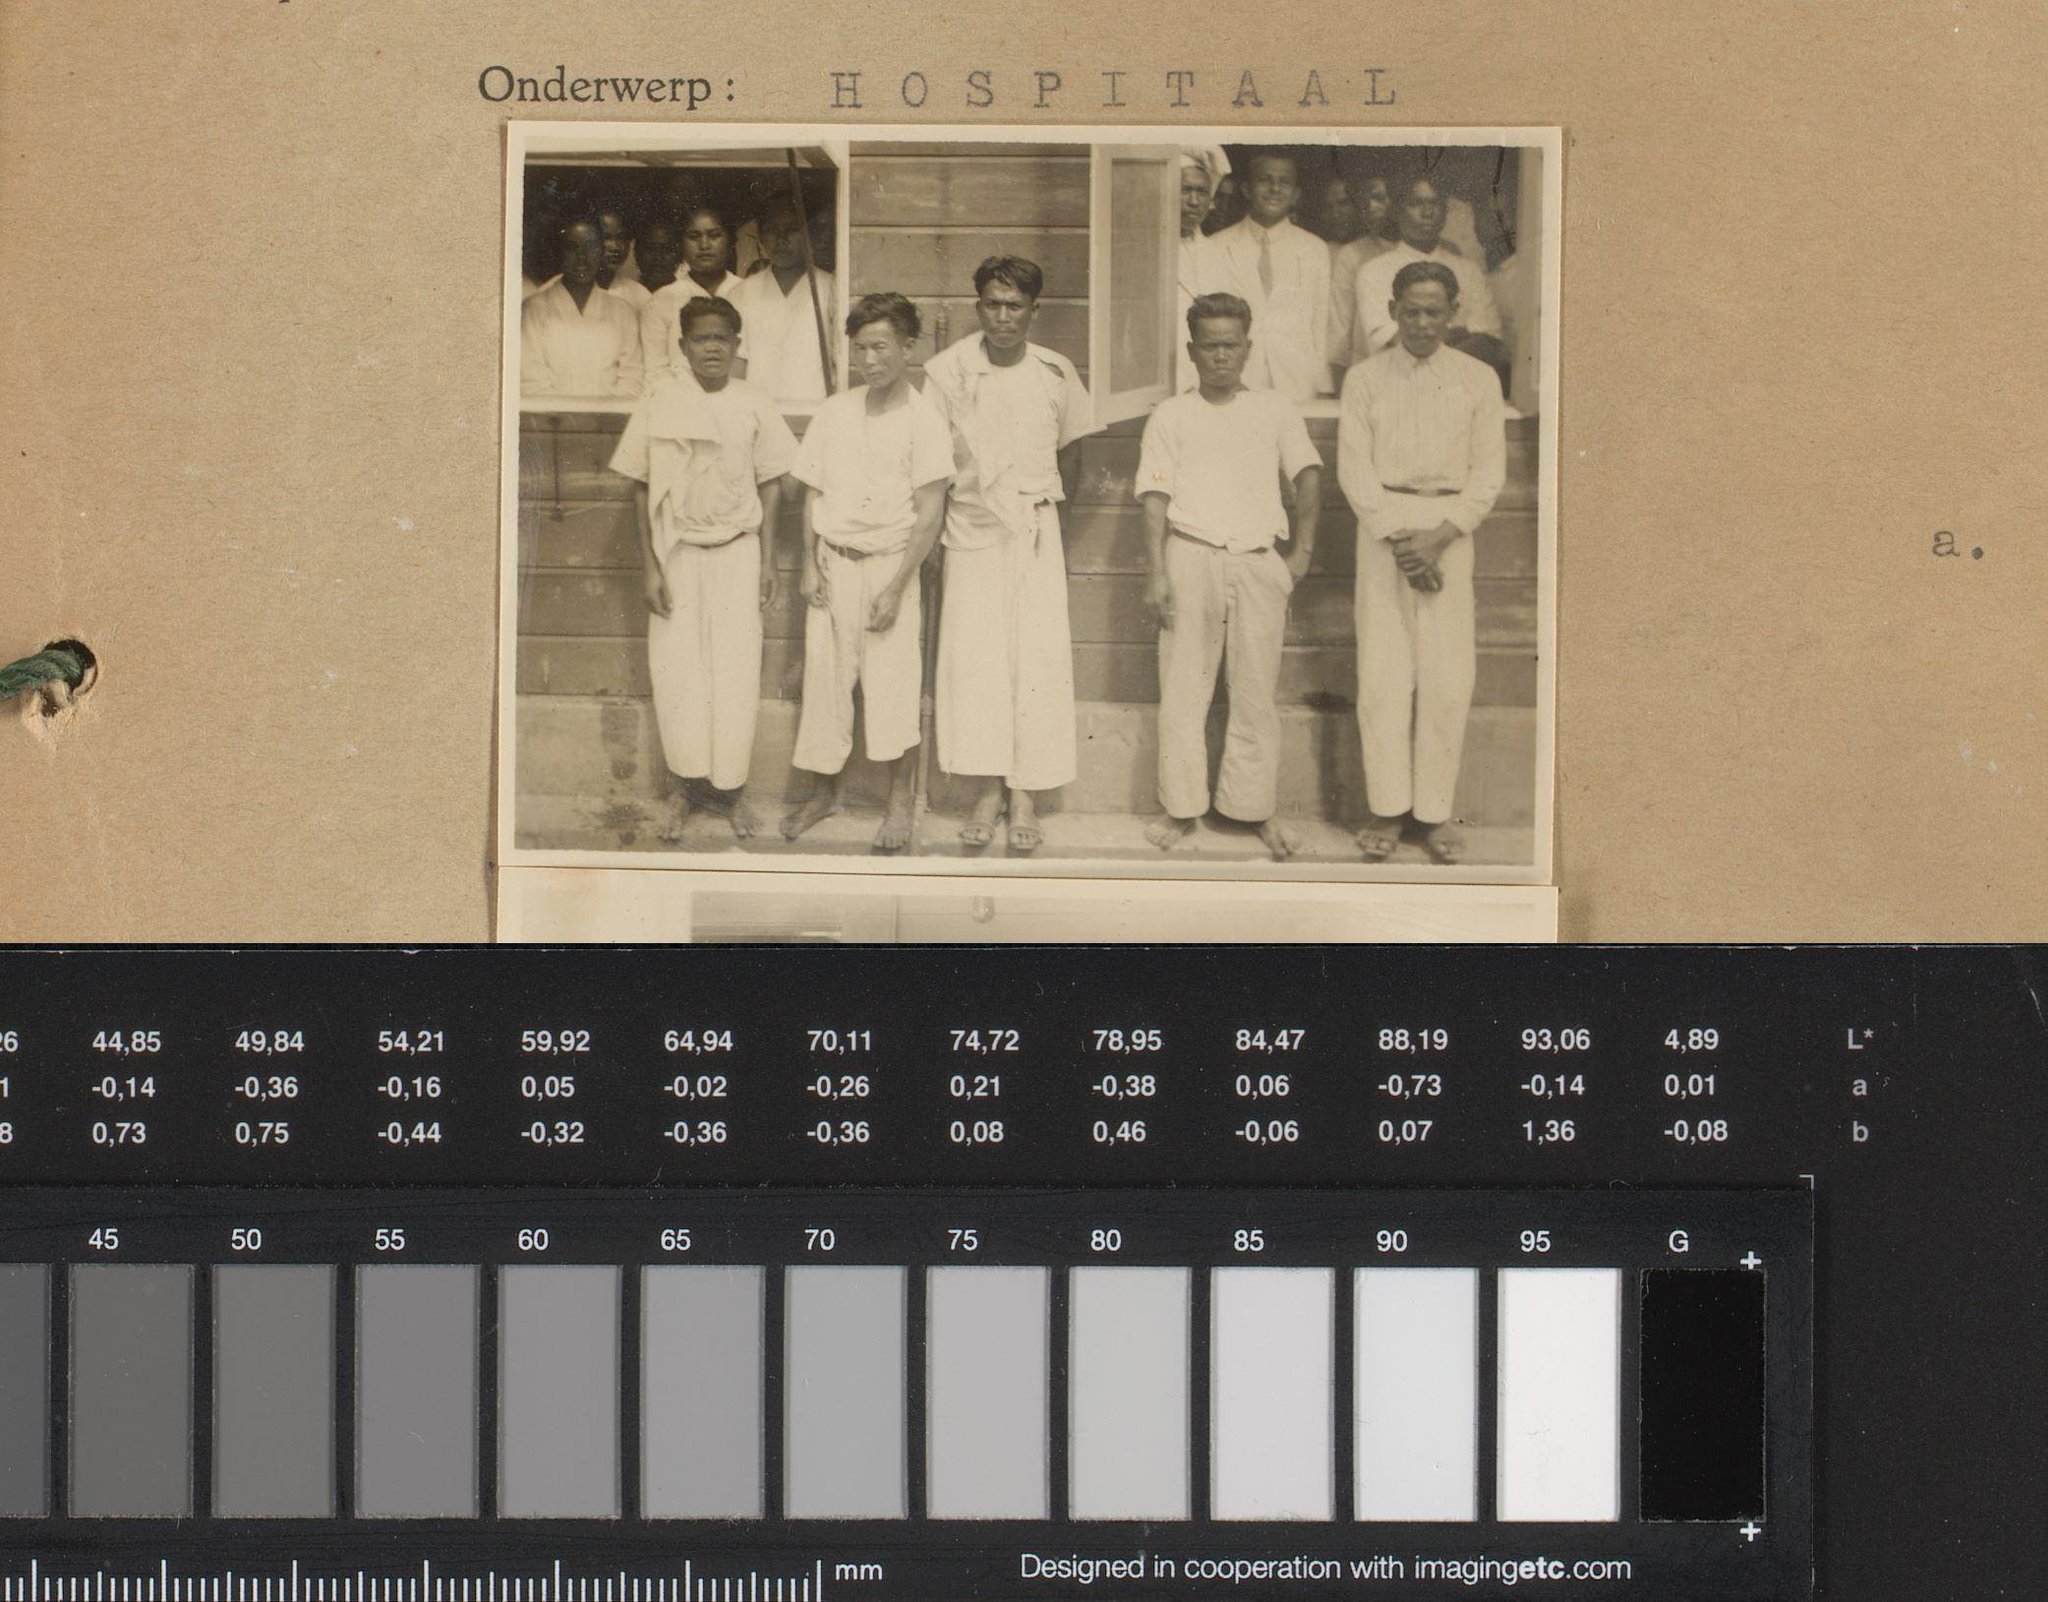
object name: photograph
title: Inwijding met "makanen besar" van verbouwde keuken en eetkamer van het personeel. Op de voorgrond rechts de twee timmerlui, links de drie kokkies.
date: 1929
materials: cardboard, photographic support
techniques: gelatin silver print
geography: kabanjahe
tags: colonial system, hospital, anonymous historical persons portrayed in a group, in a group-portrait, sumatra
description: Foto (a) van de timmerlieden en de koks poserend voor de verbouwde keuken en eetkamer van het personeel van het hospitaal. Datum van foto: 17 november 1929. Foto geplakt op voorgedrukt kartonnen blad ingebonden in het fotoalbum over het Hospitaal Batak Instituut te Kabanjaheh op Sumatra in de jaren 1926-1929.